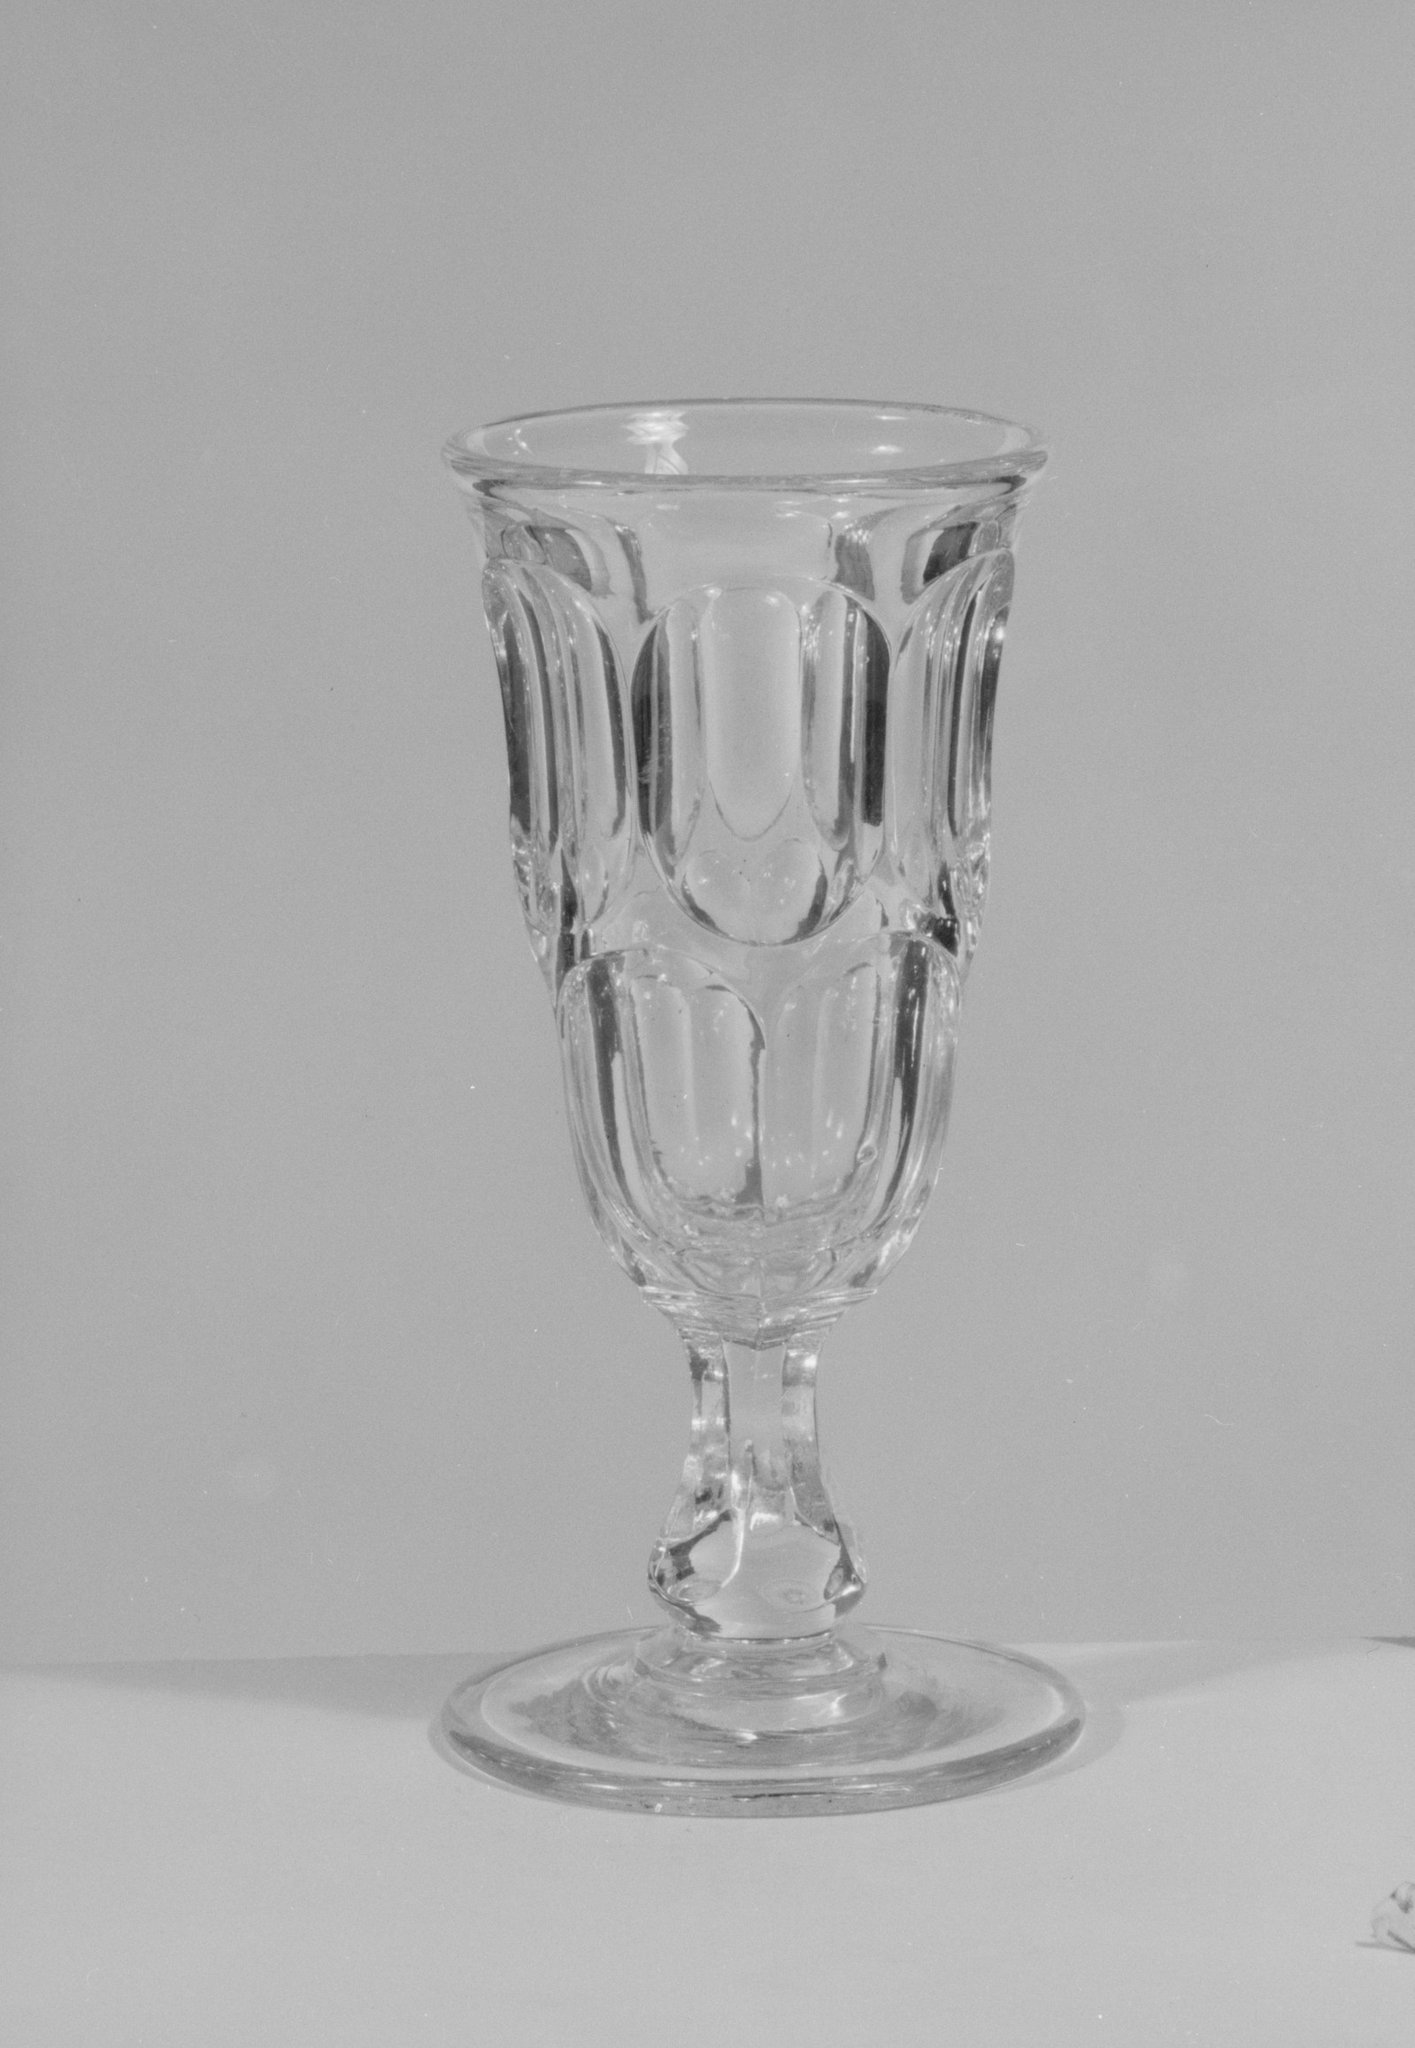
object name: parfait glass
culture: american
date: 1830-1870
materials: glass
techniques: pressed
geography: united states